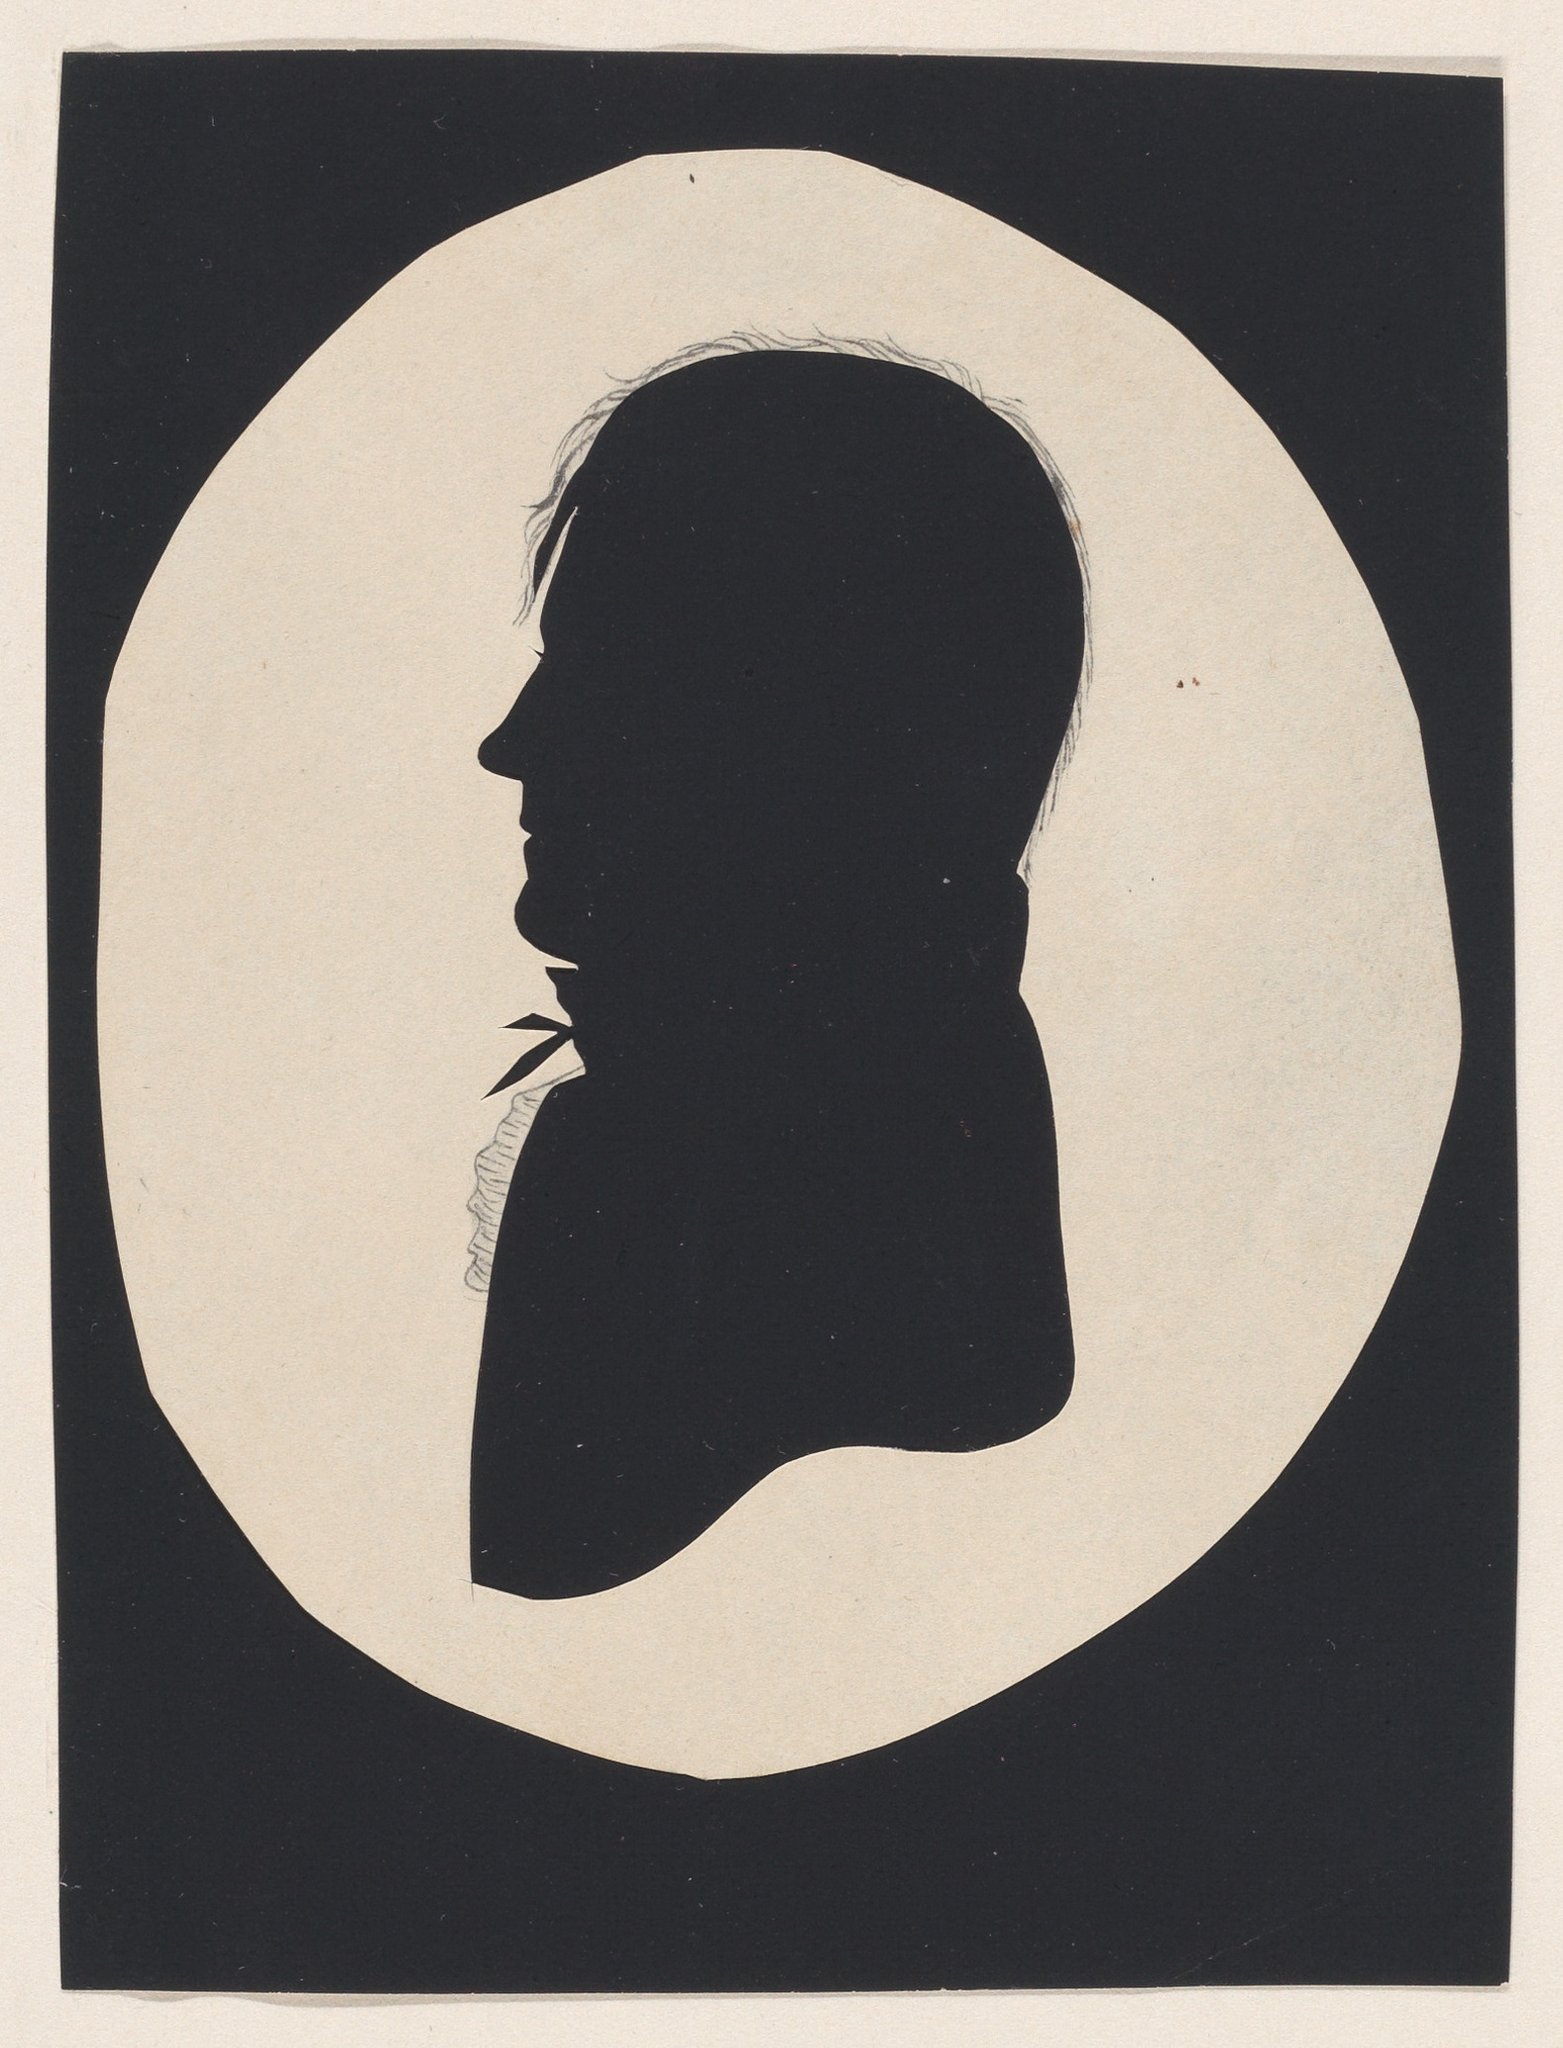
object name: cut paper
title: Silhouette of an unknown man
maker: moses chapman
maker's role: artist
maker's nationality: american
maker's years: 1783-1821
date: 1803-1821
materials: ink, paper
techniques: cutting, pen